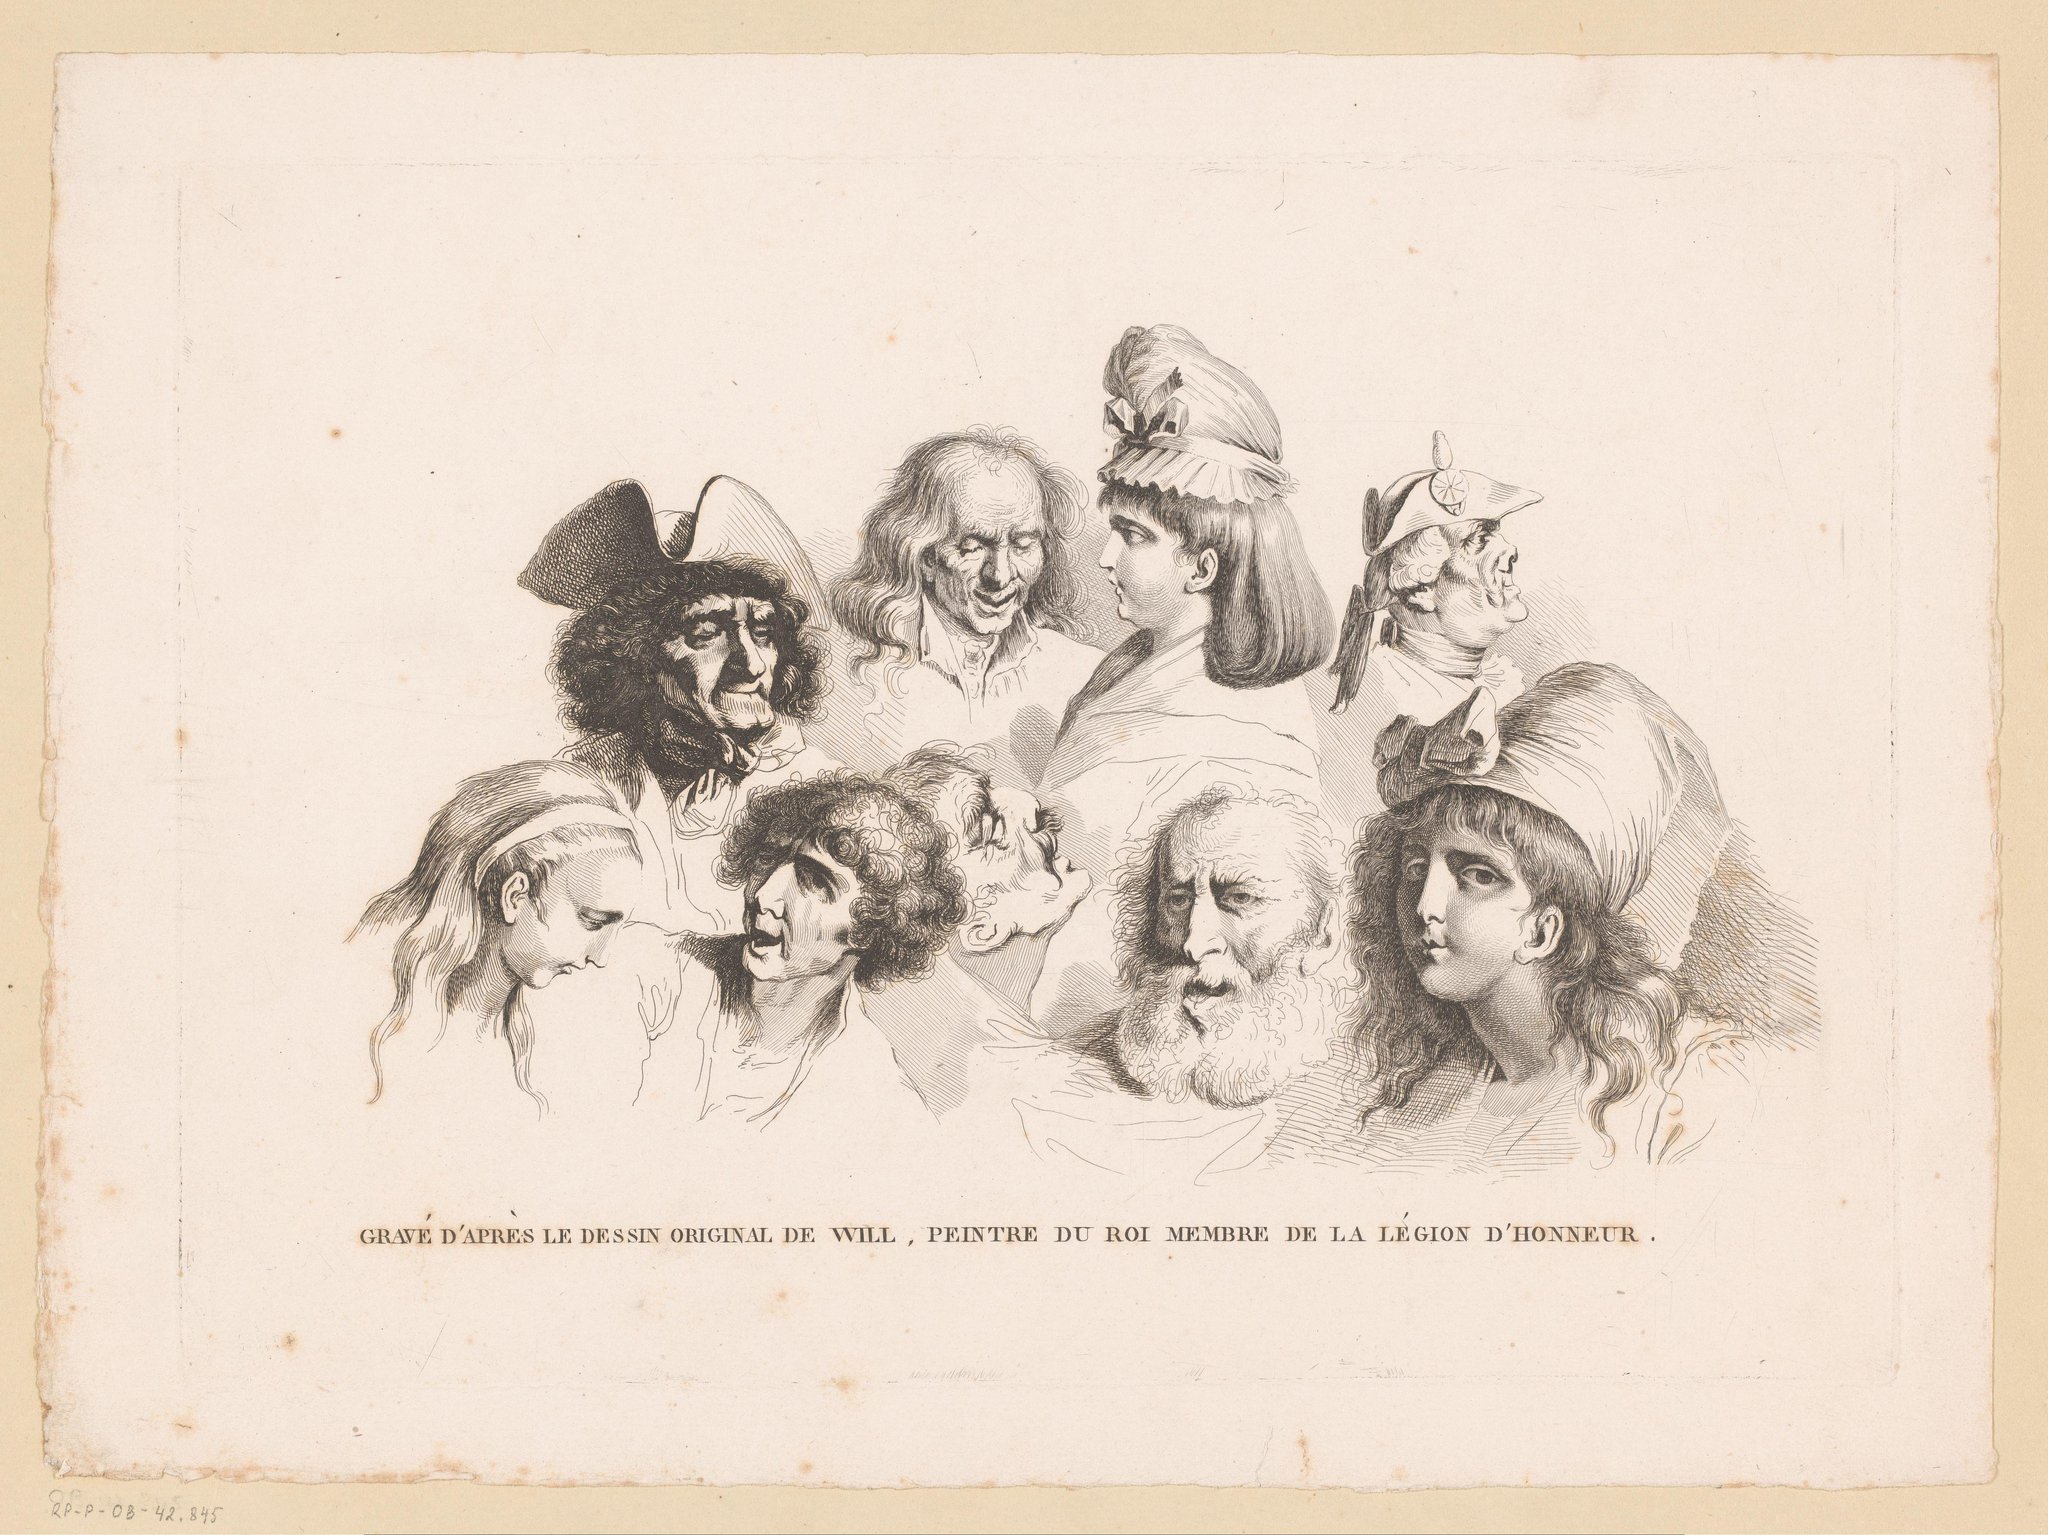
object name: print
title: Compositie met negen hoofden van mannen en vrouwen van verschillende leeftijden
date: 1805-1844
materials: paper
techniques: engraving, etching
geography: france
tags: adolescent, young woman, maiden, head-gear, old man